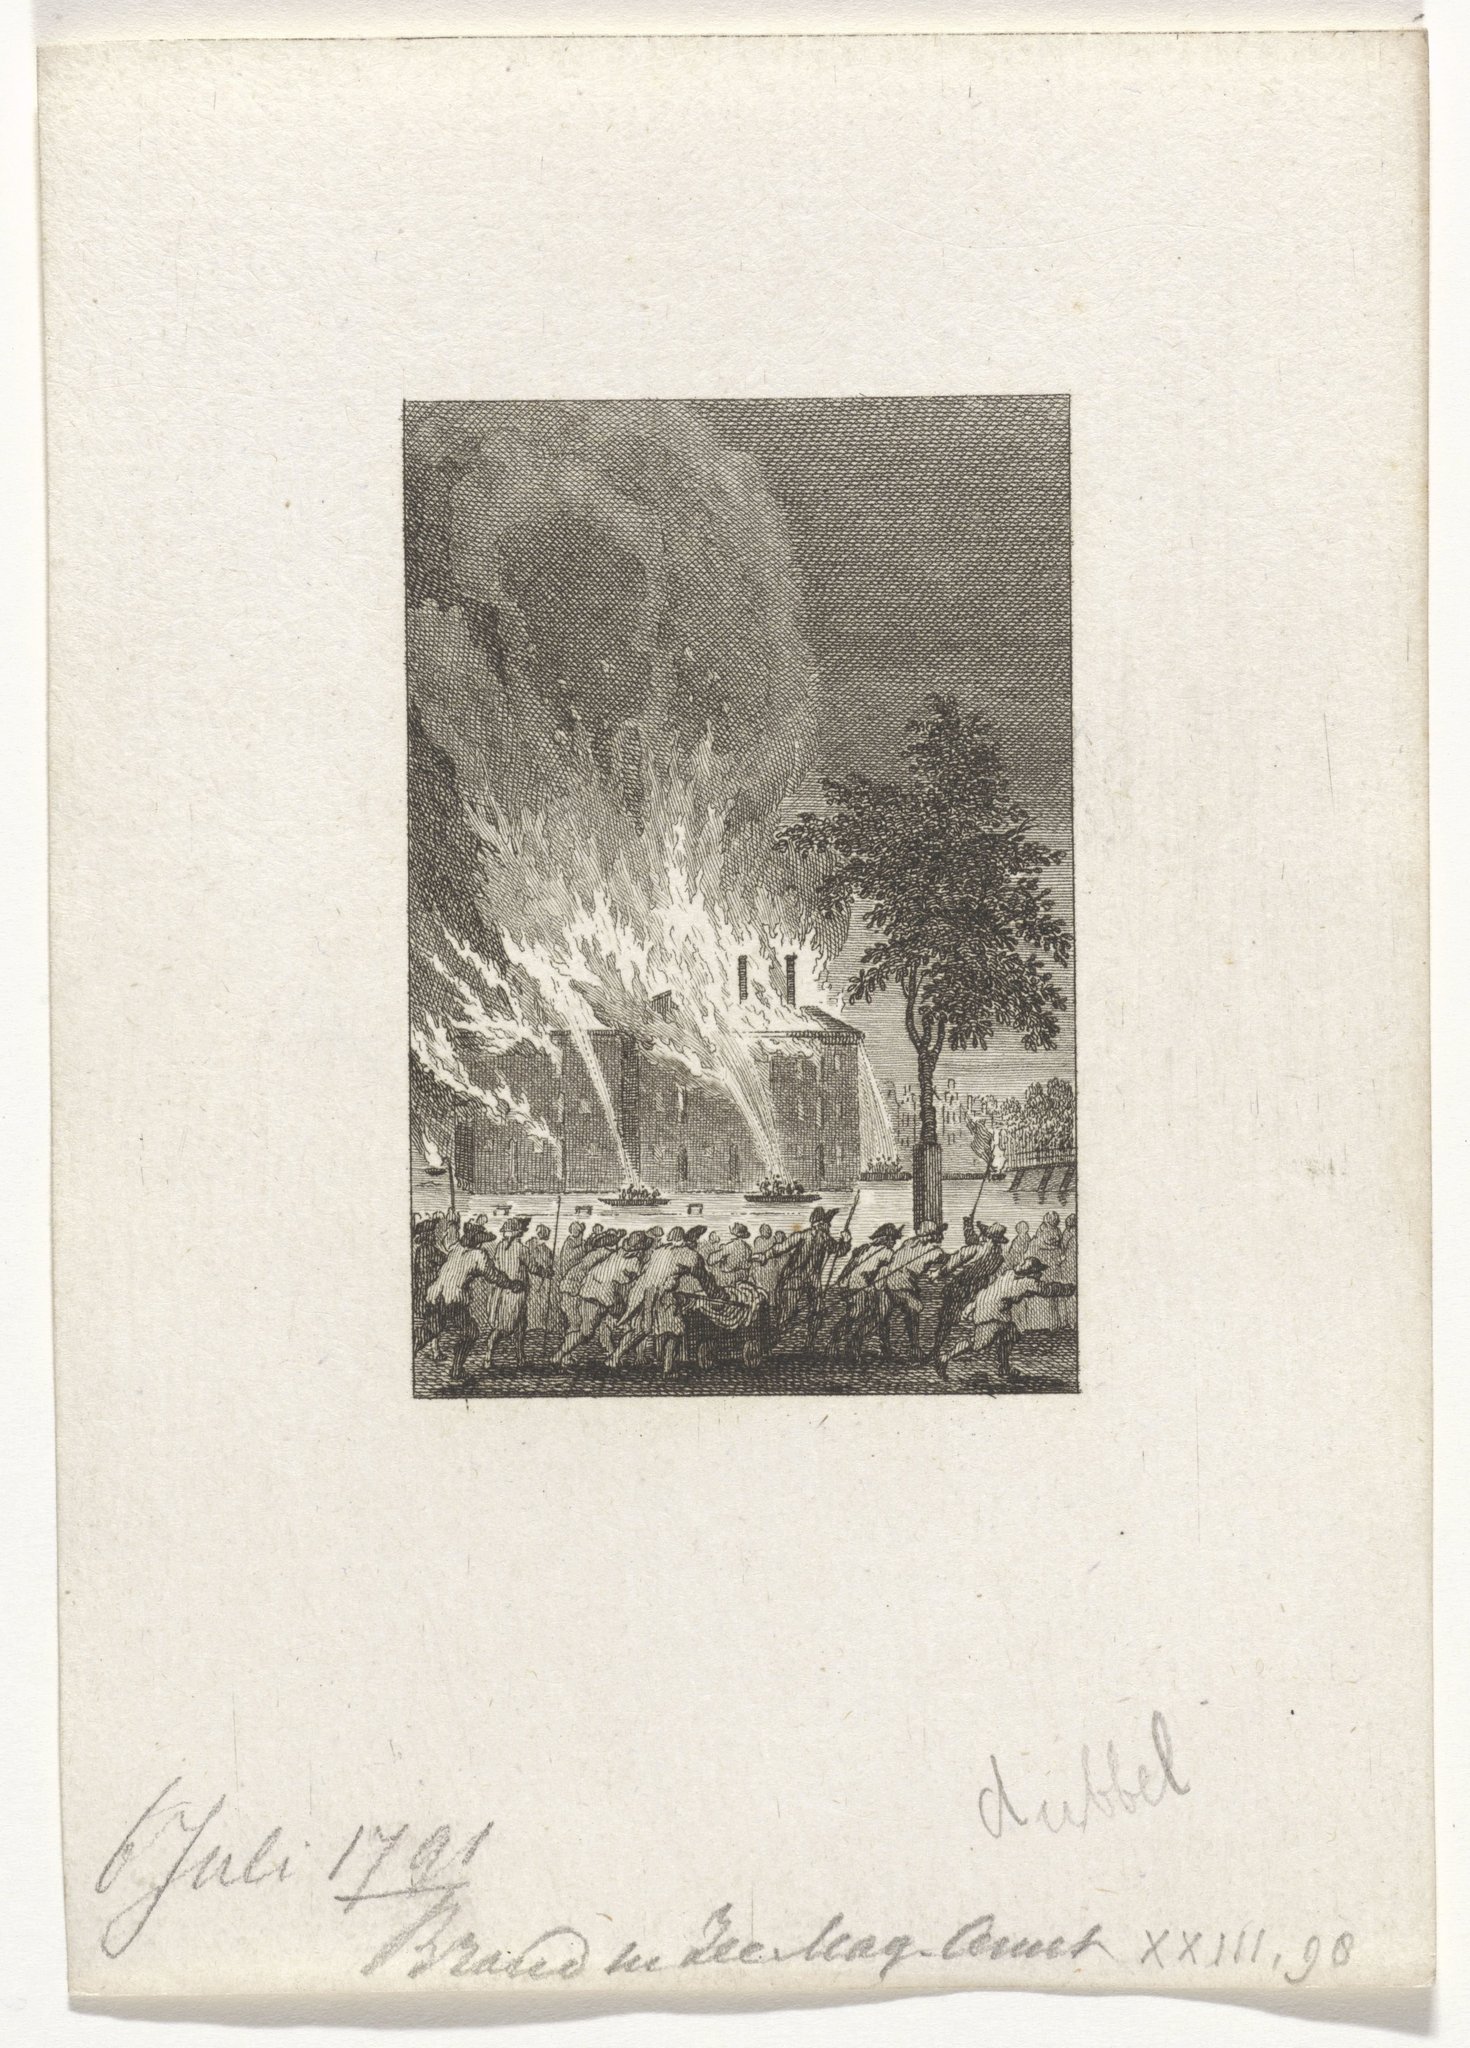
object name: history print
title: Brand in 's Lands Zeemagazijn, 1791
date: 1783-1795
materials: paper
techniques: etching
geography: amsterdam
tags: on fire, ablaze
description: Illustratie voor: J. Fokke. Geschiedenissen der Vereenigde Nederlanden voor de vaderlandsche jeugd. Amsterdam: Johannes Allart, 1783-1795, 25 delen. deel XXIII pl. VI.